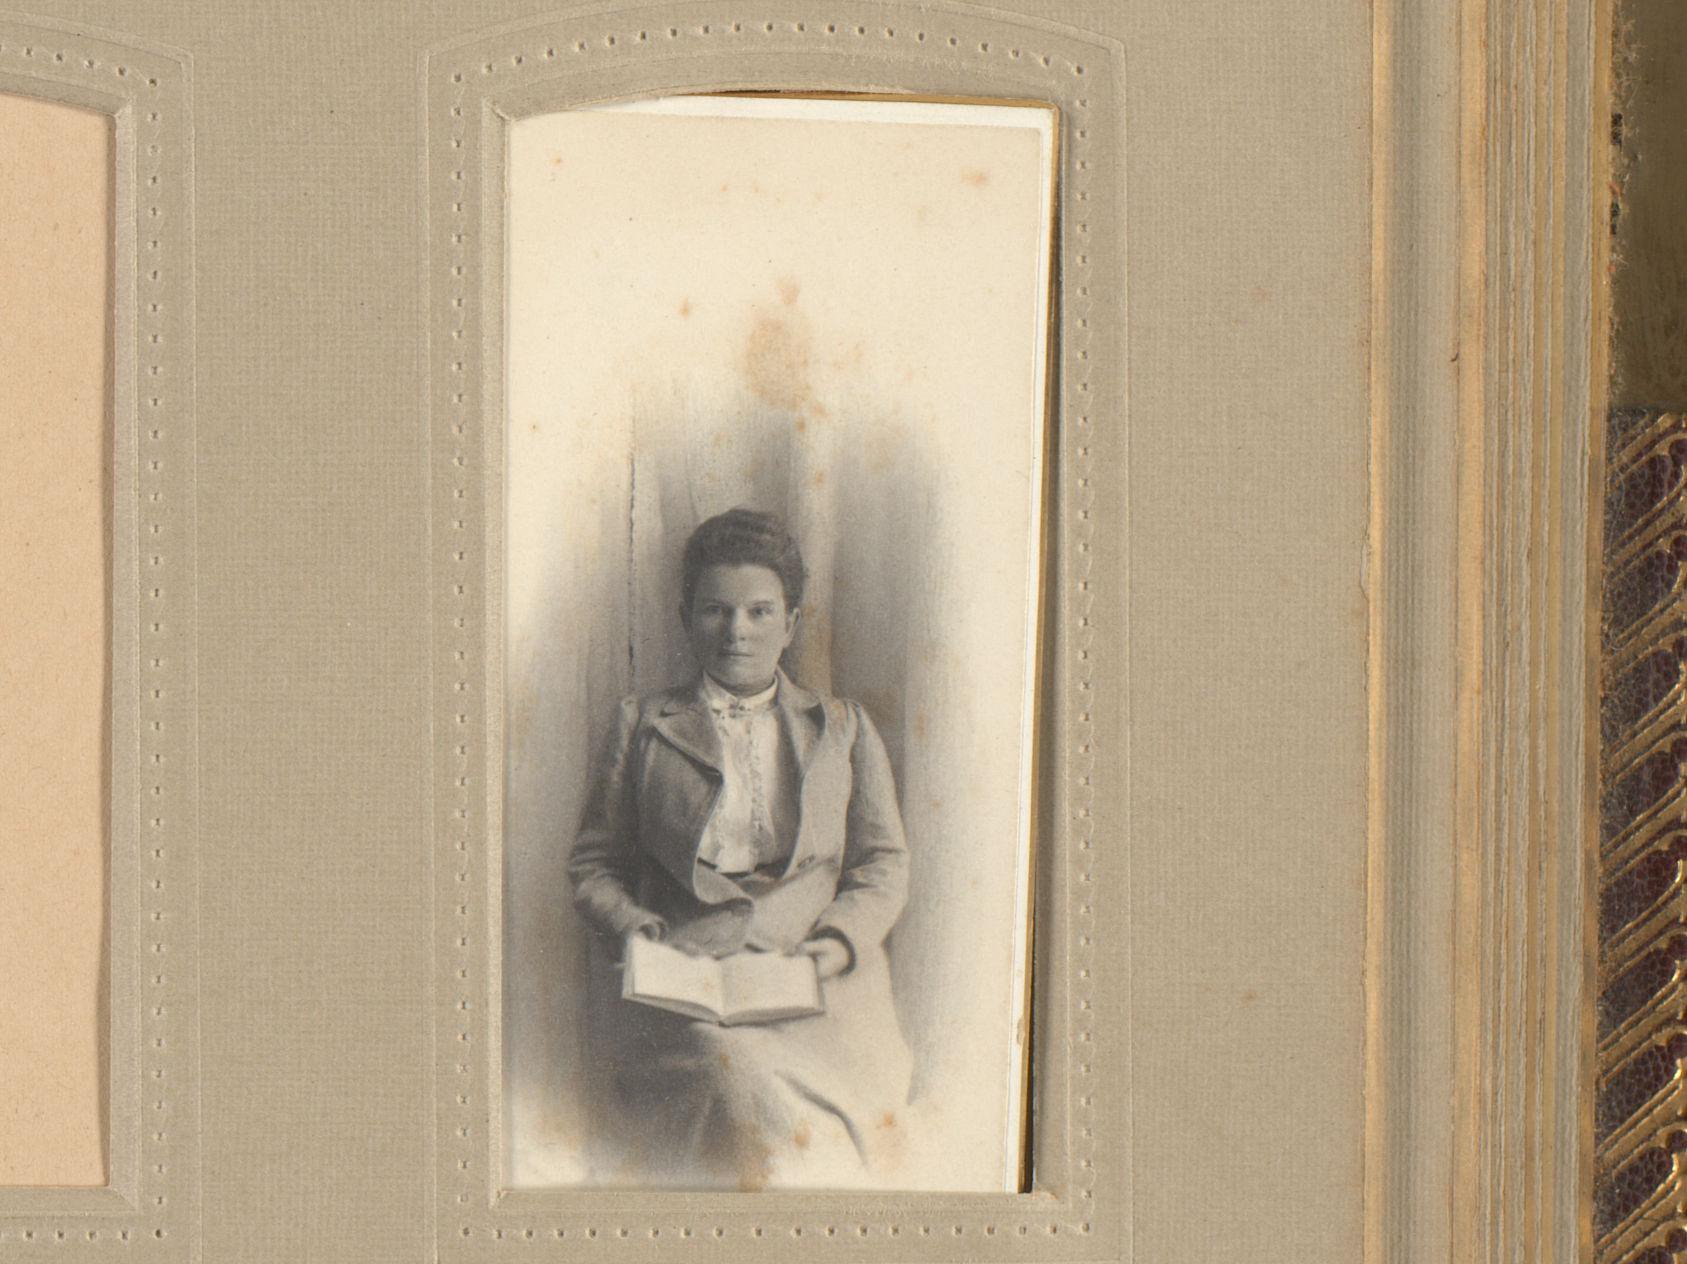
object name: carte de visite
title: Studioportret van Margo J.J. Kessler-de Lange met een boek op schoot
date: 1900-1910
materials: paper, photographic support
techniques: gelatin silver print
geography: the hague